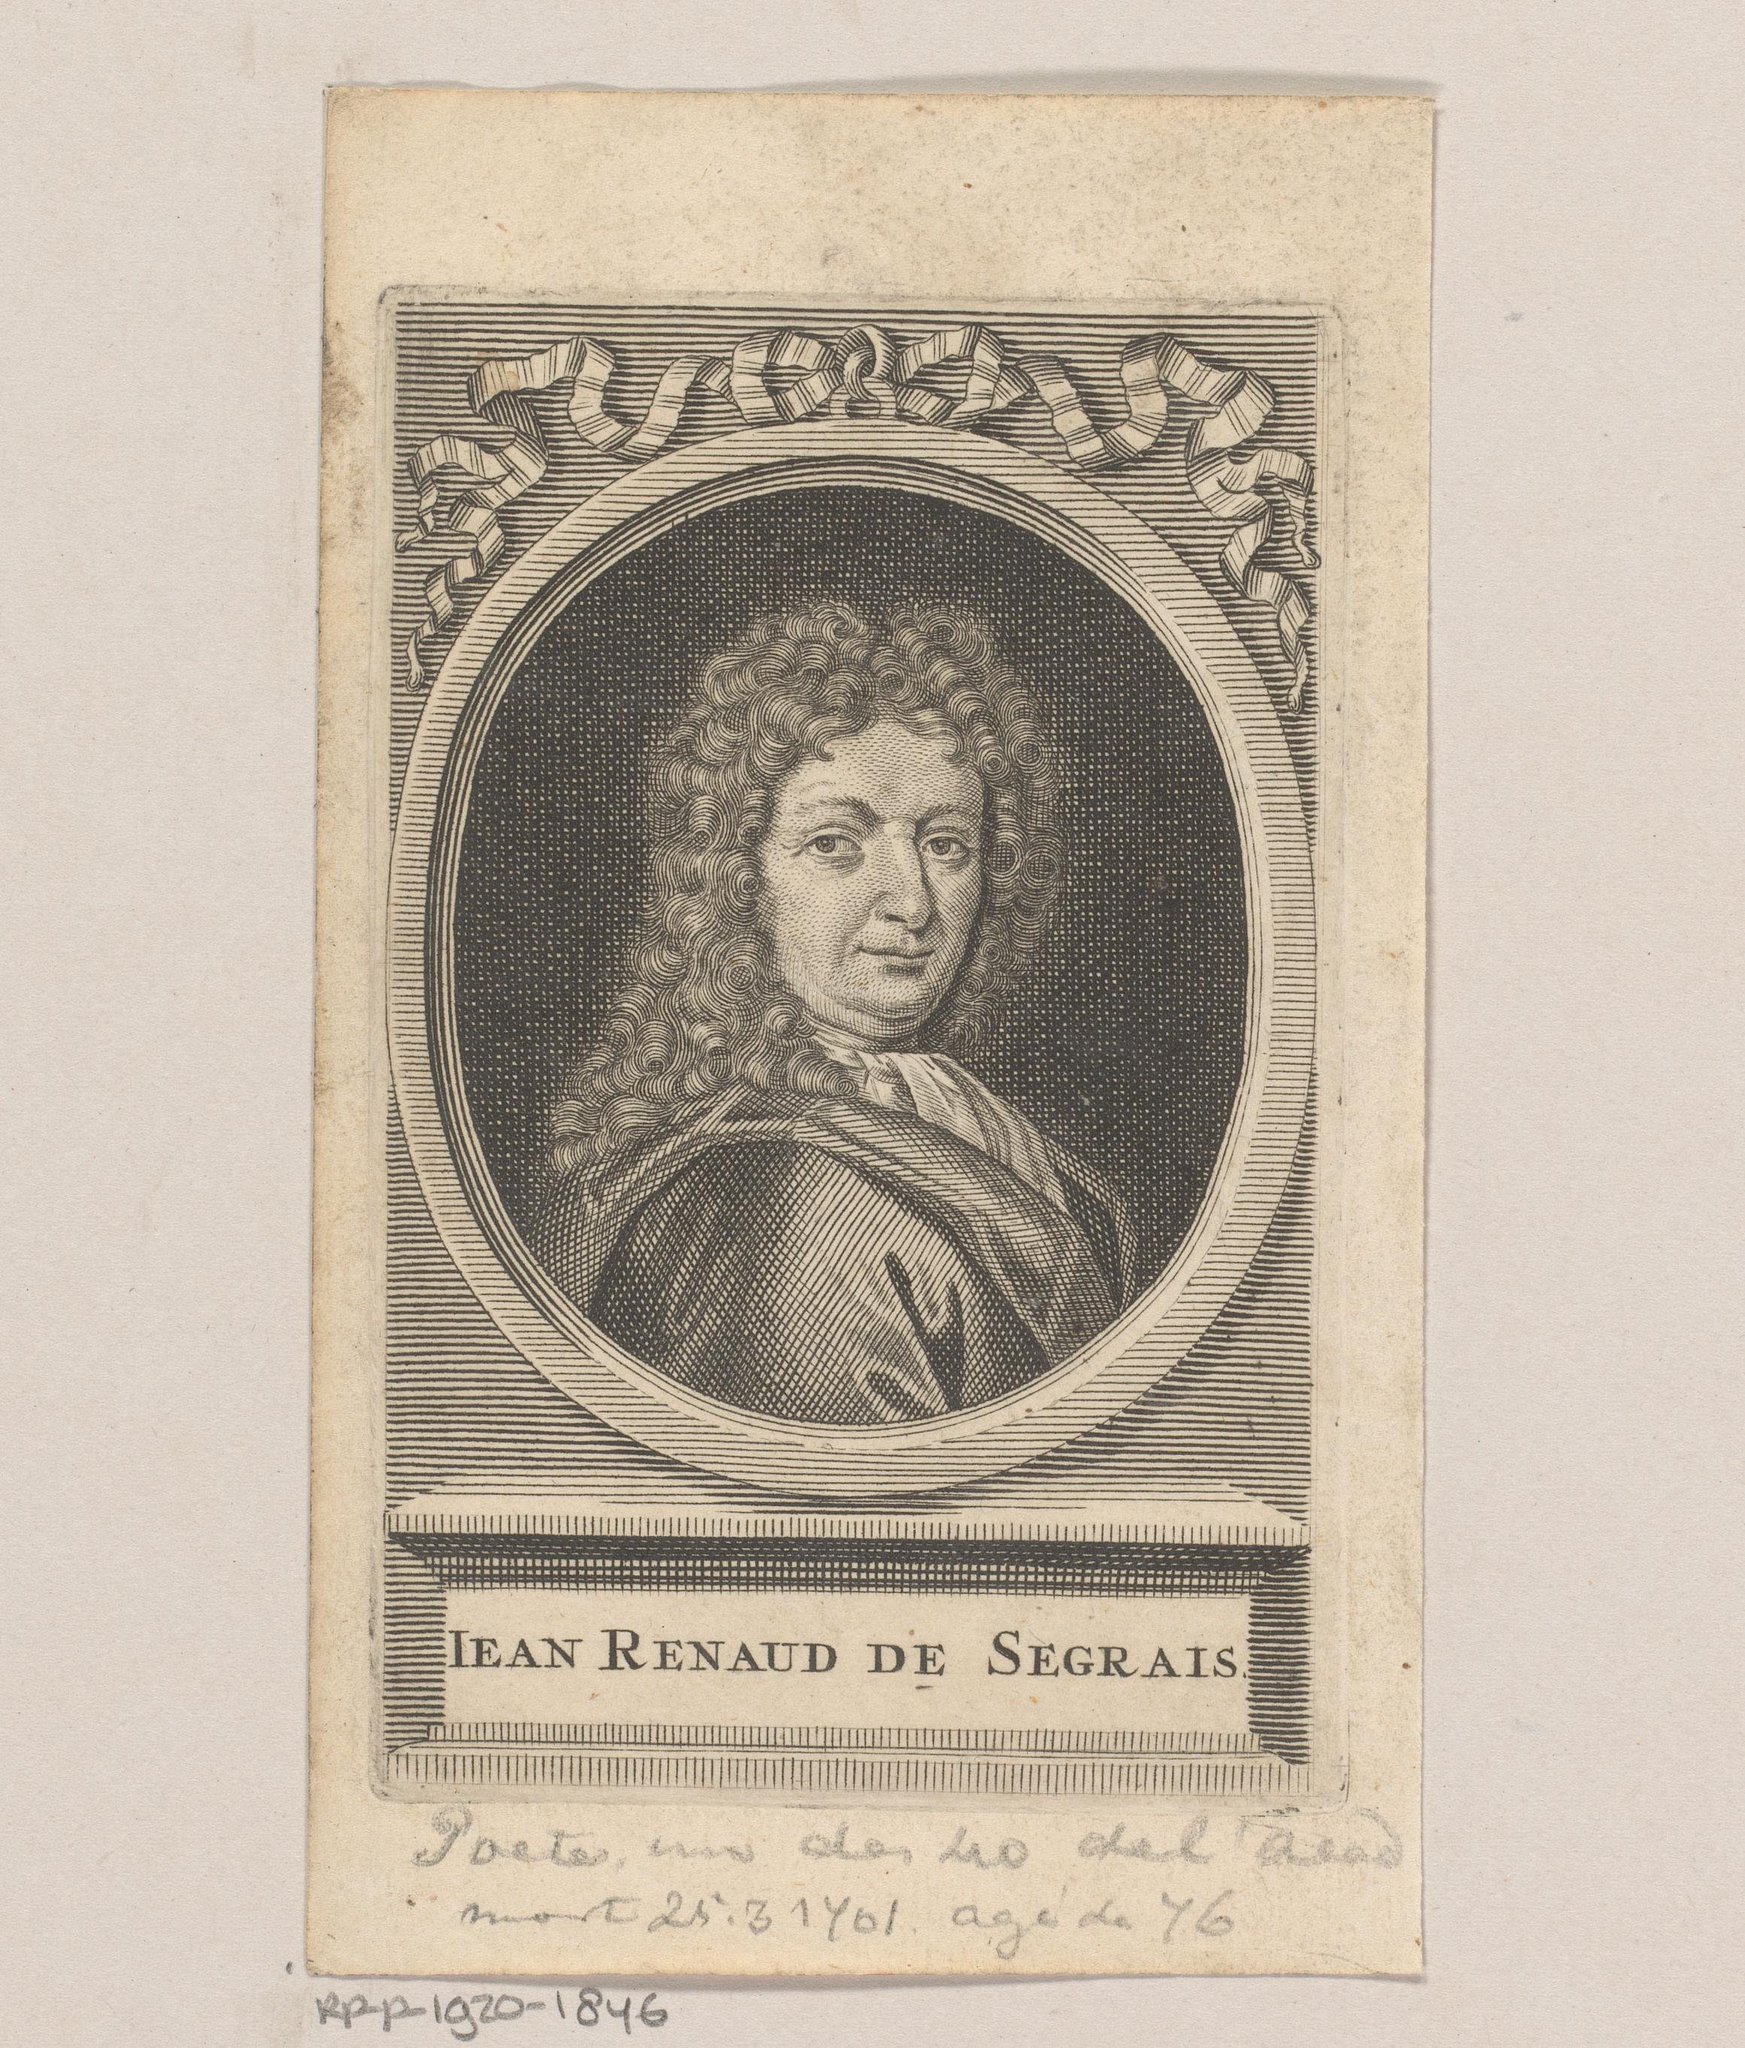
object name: print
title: Portret van Jean Regnault de Segrais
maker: Anonymous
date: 1654-1750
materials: paper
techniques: engraving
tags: historical persons, portrait of a writer, writer, poet, author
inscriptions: inscription: ‘Poete [...] des [...] de Caen (?) / mort 25 3 1701 age de 76’, collector's mark: Lugt 2228